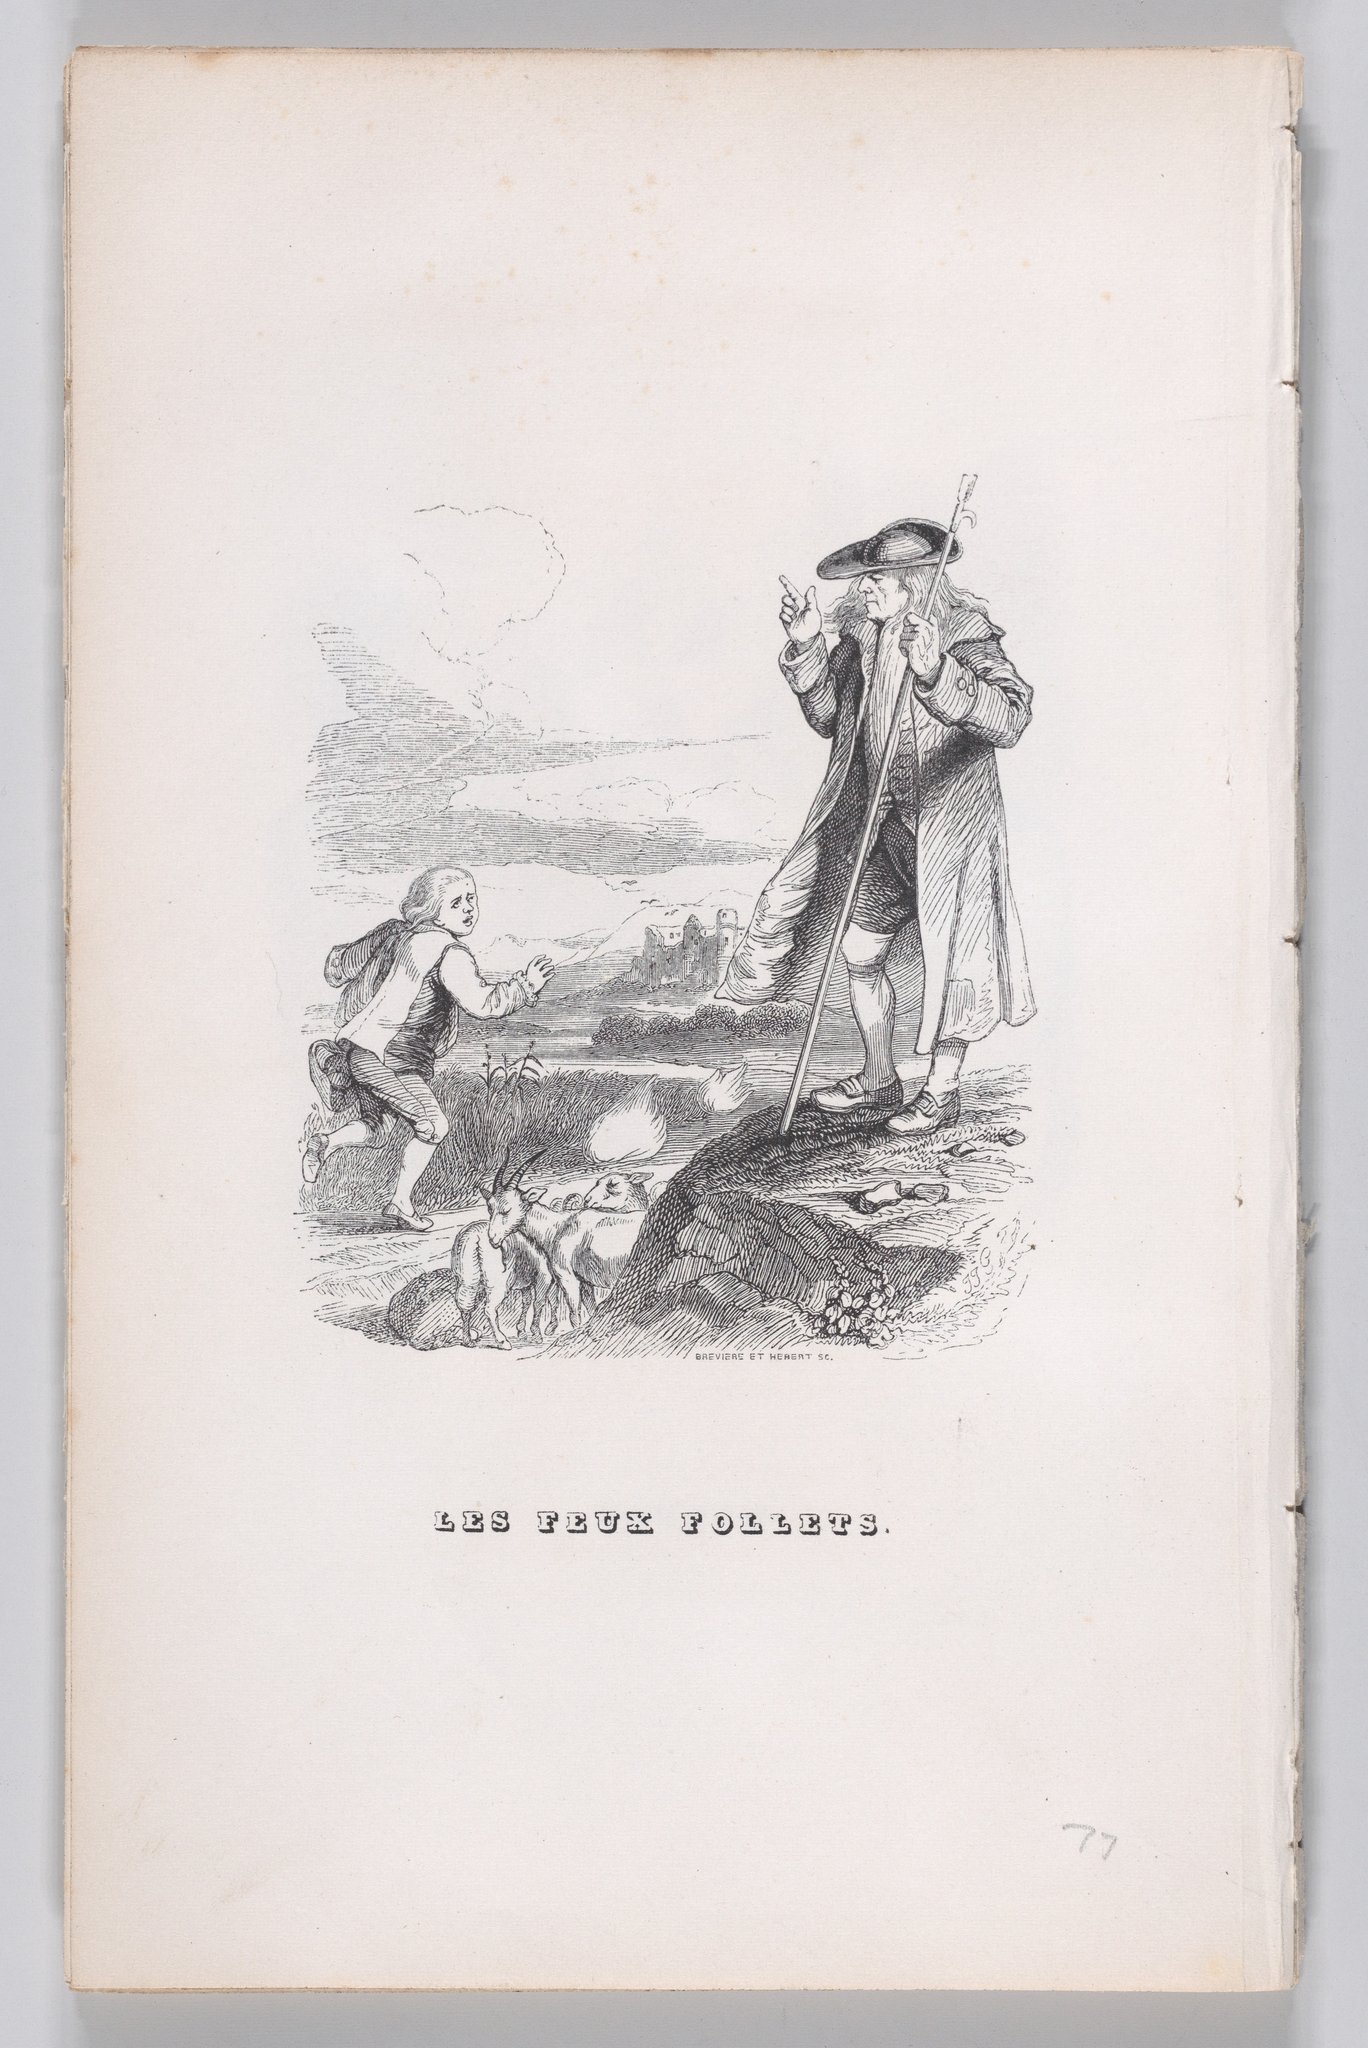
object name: print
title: Will-o'-the-wisp, from "The Complete Works of Béranger"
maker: j. j. grandville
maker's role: illustrator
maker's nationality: french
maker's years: 1803-1847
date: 1836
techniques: engraving